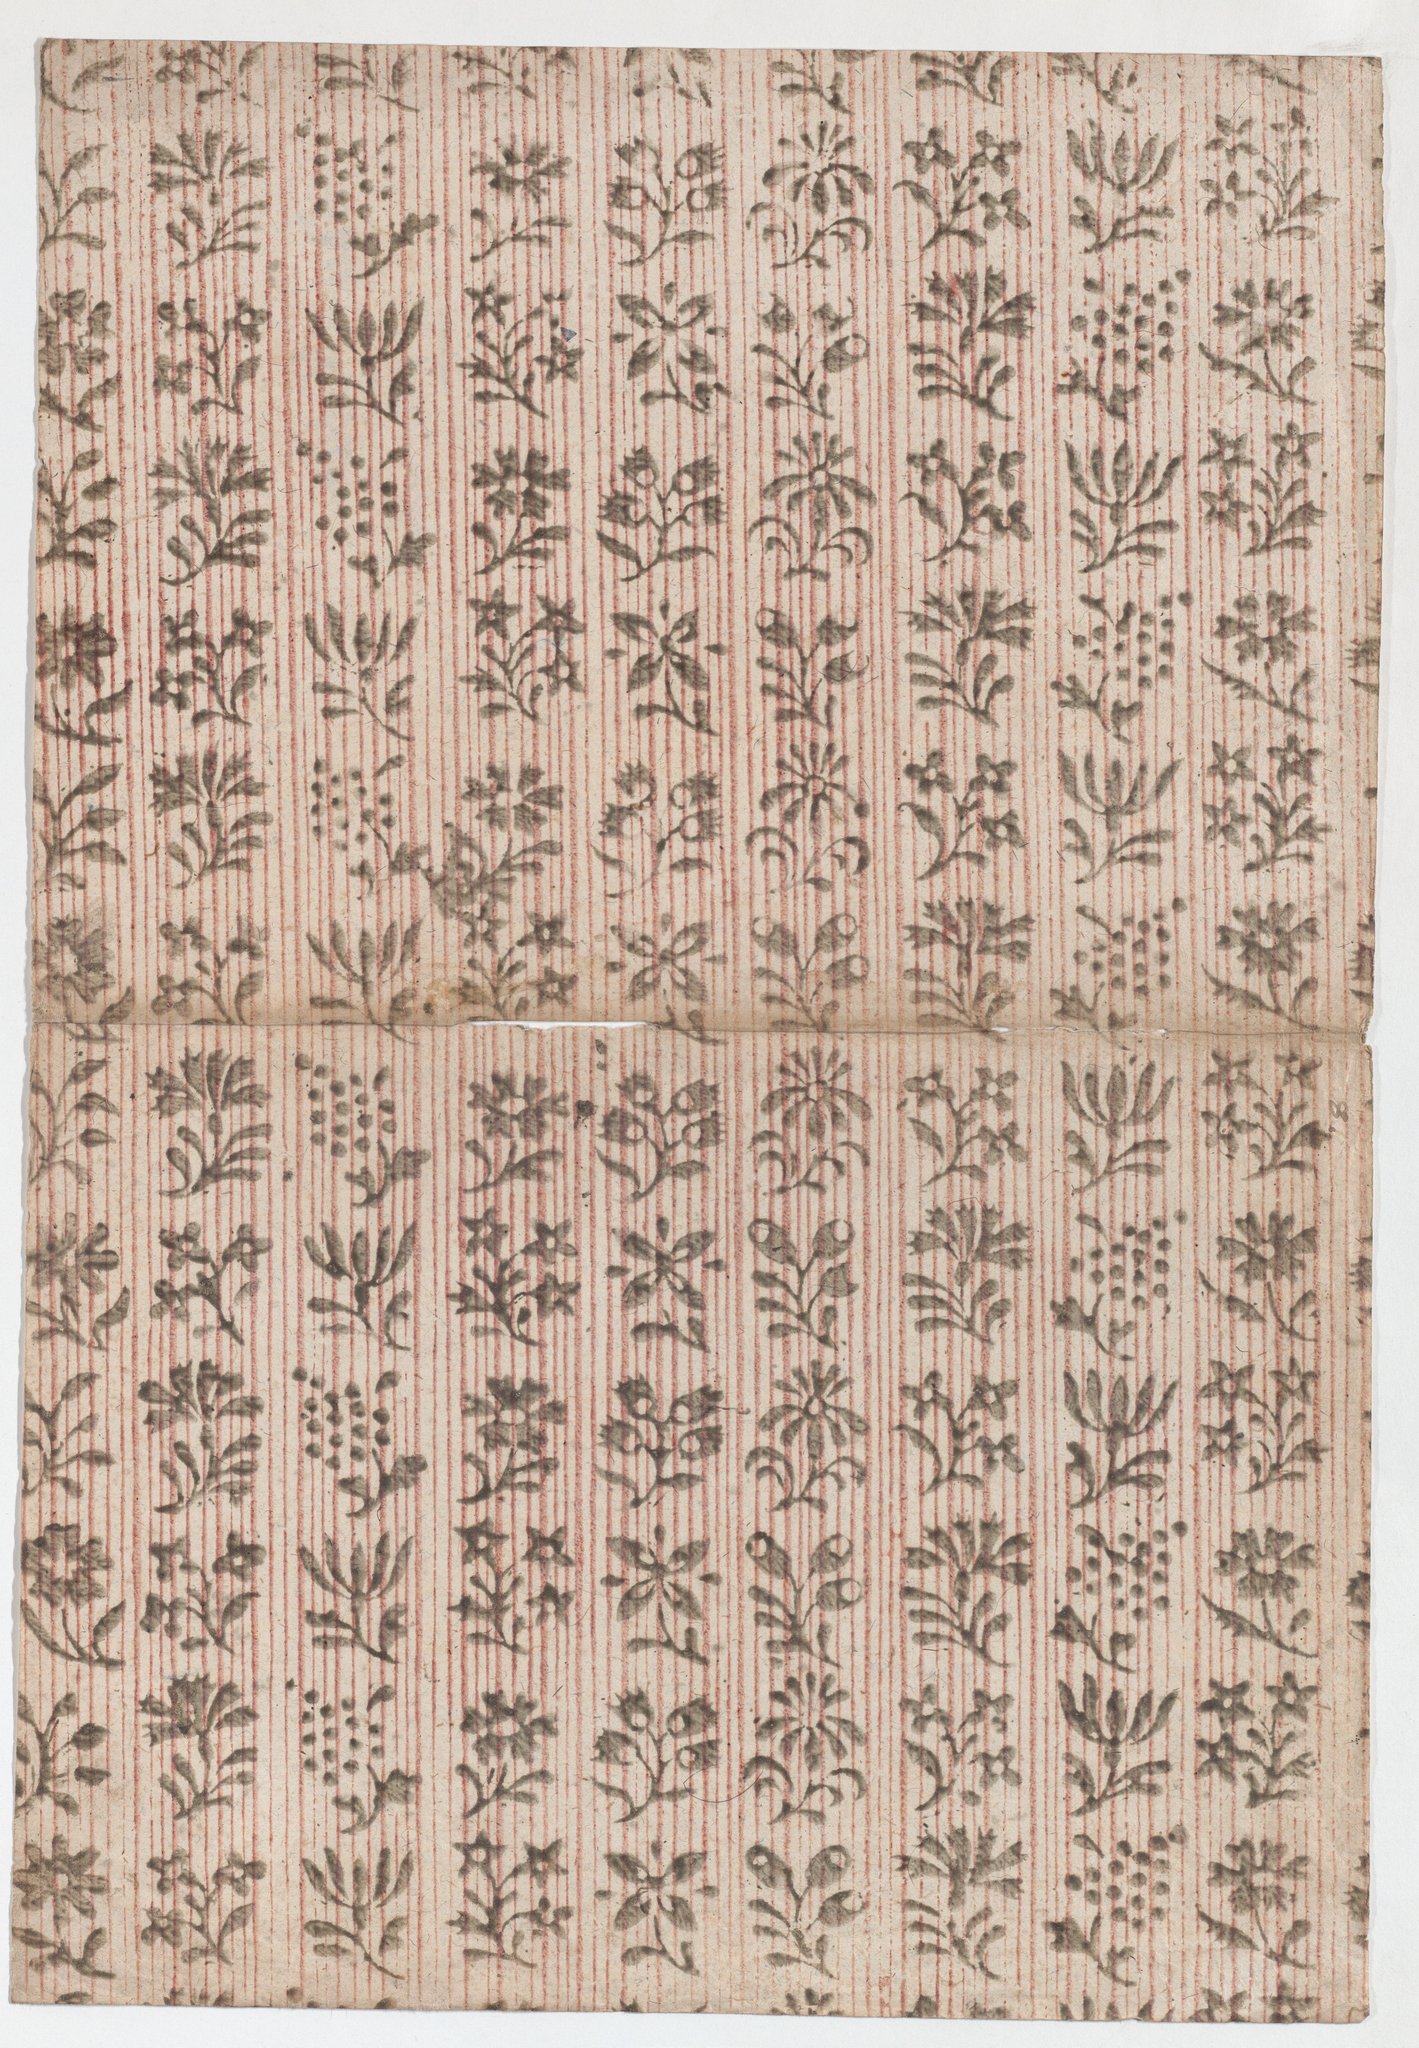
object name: print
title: Book cover with overall stripe pattern with floral designs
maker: Anonymous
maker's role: artist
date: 1801-1900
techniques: relief print